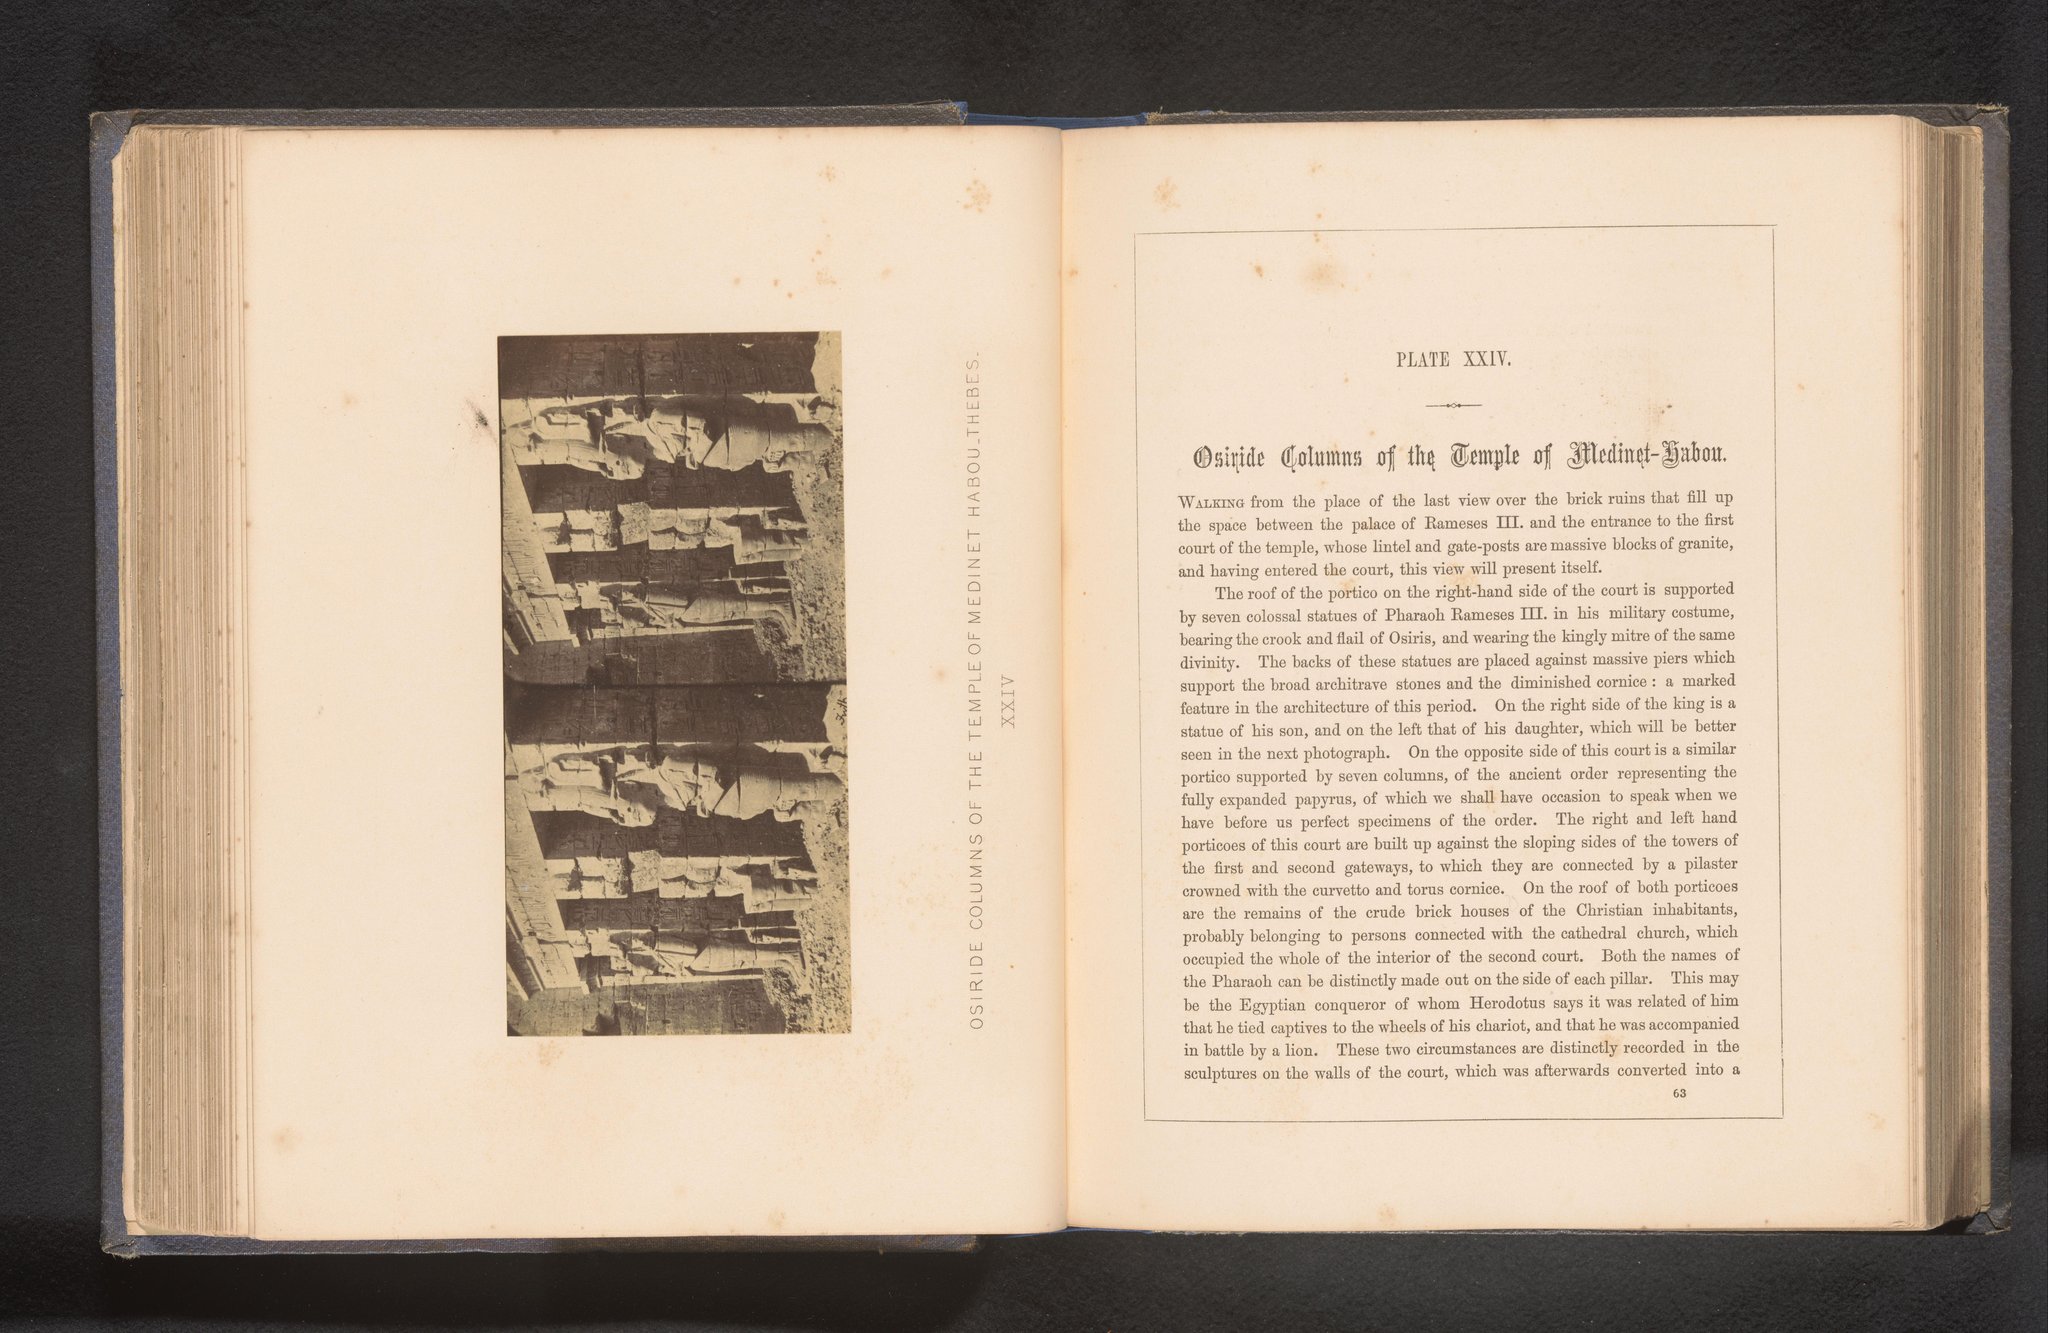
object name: stereograph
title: Osiride columns of the temple of Medinet Habou - Thebes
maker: francis frith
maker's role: publisher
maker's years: 1822-1898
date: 1857-1862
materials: photographic support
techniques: albumen print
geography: medinet habu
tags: temple, shrine ~ egyptian religion, osiris, god of the underworld, capital (~ column, pillar)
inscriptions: number: ‘XXIV’, name: ‘Frith’